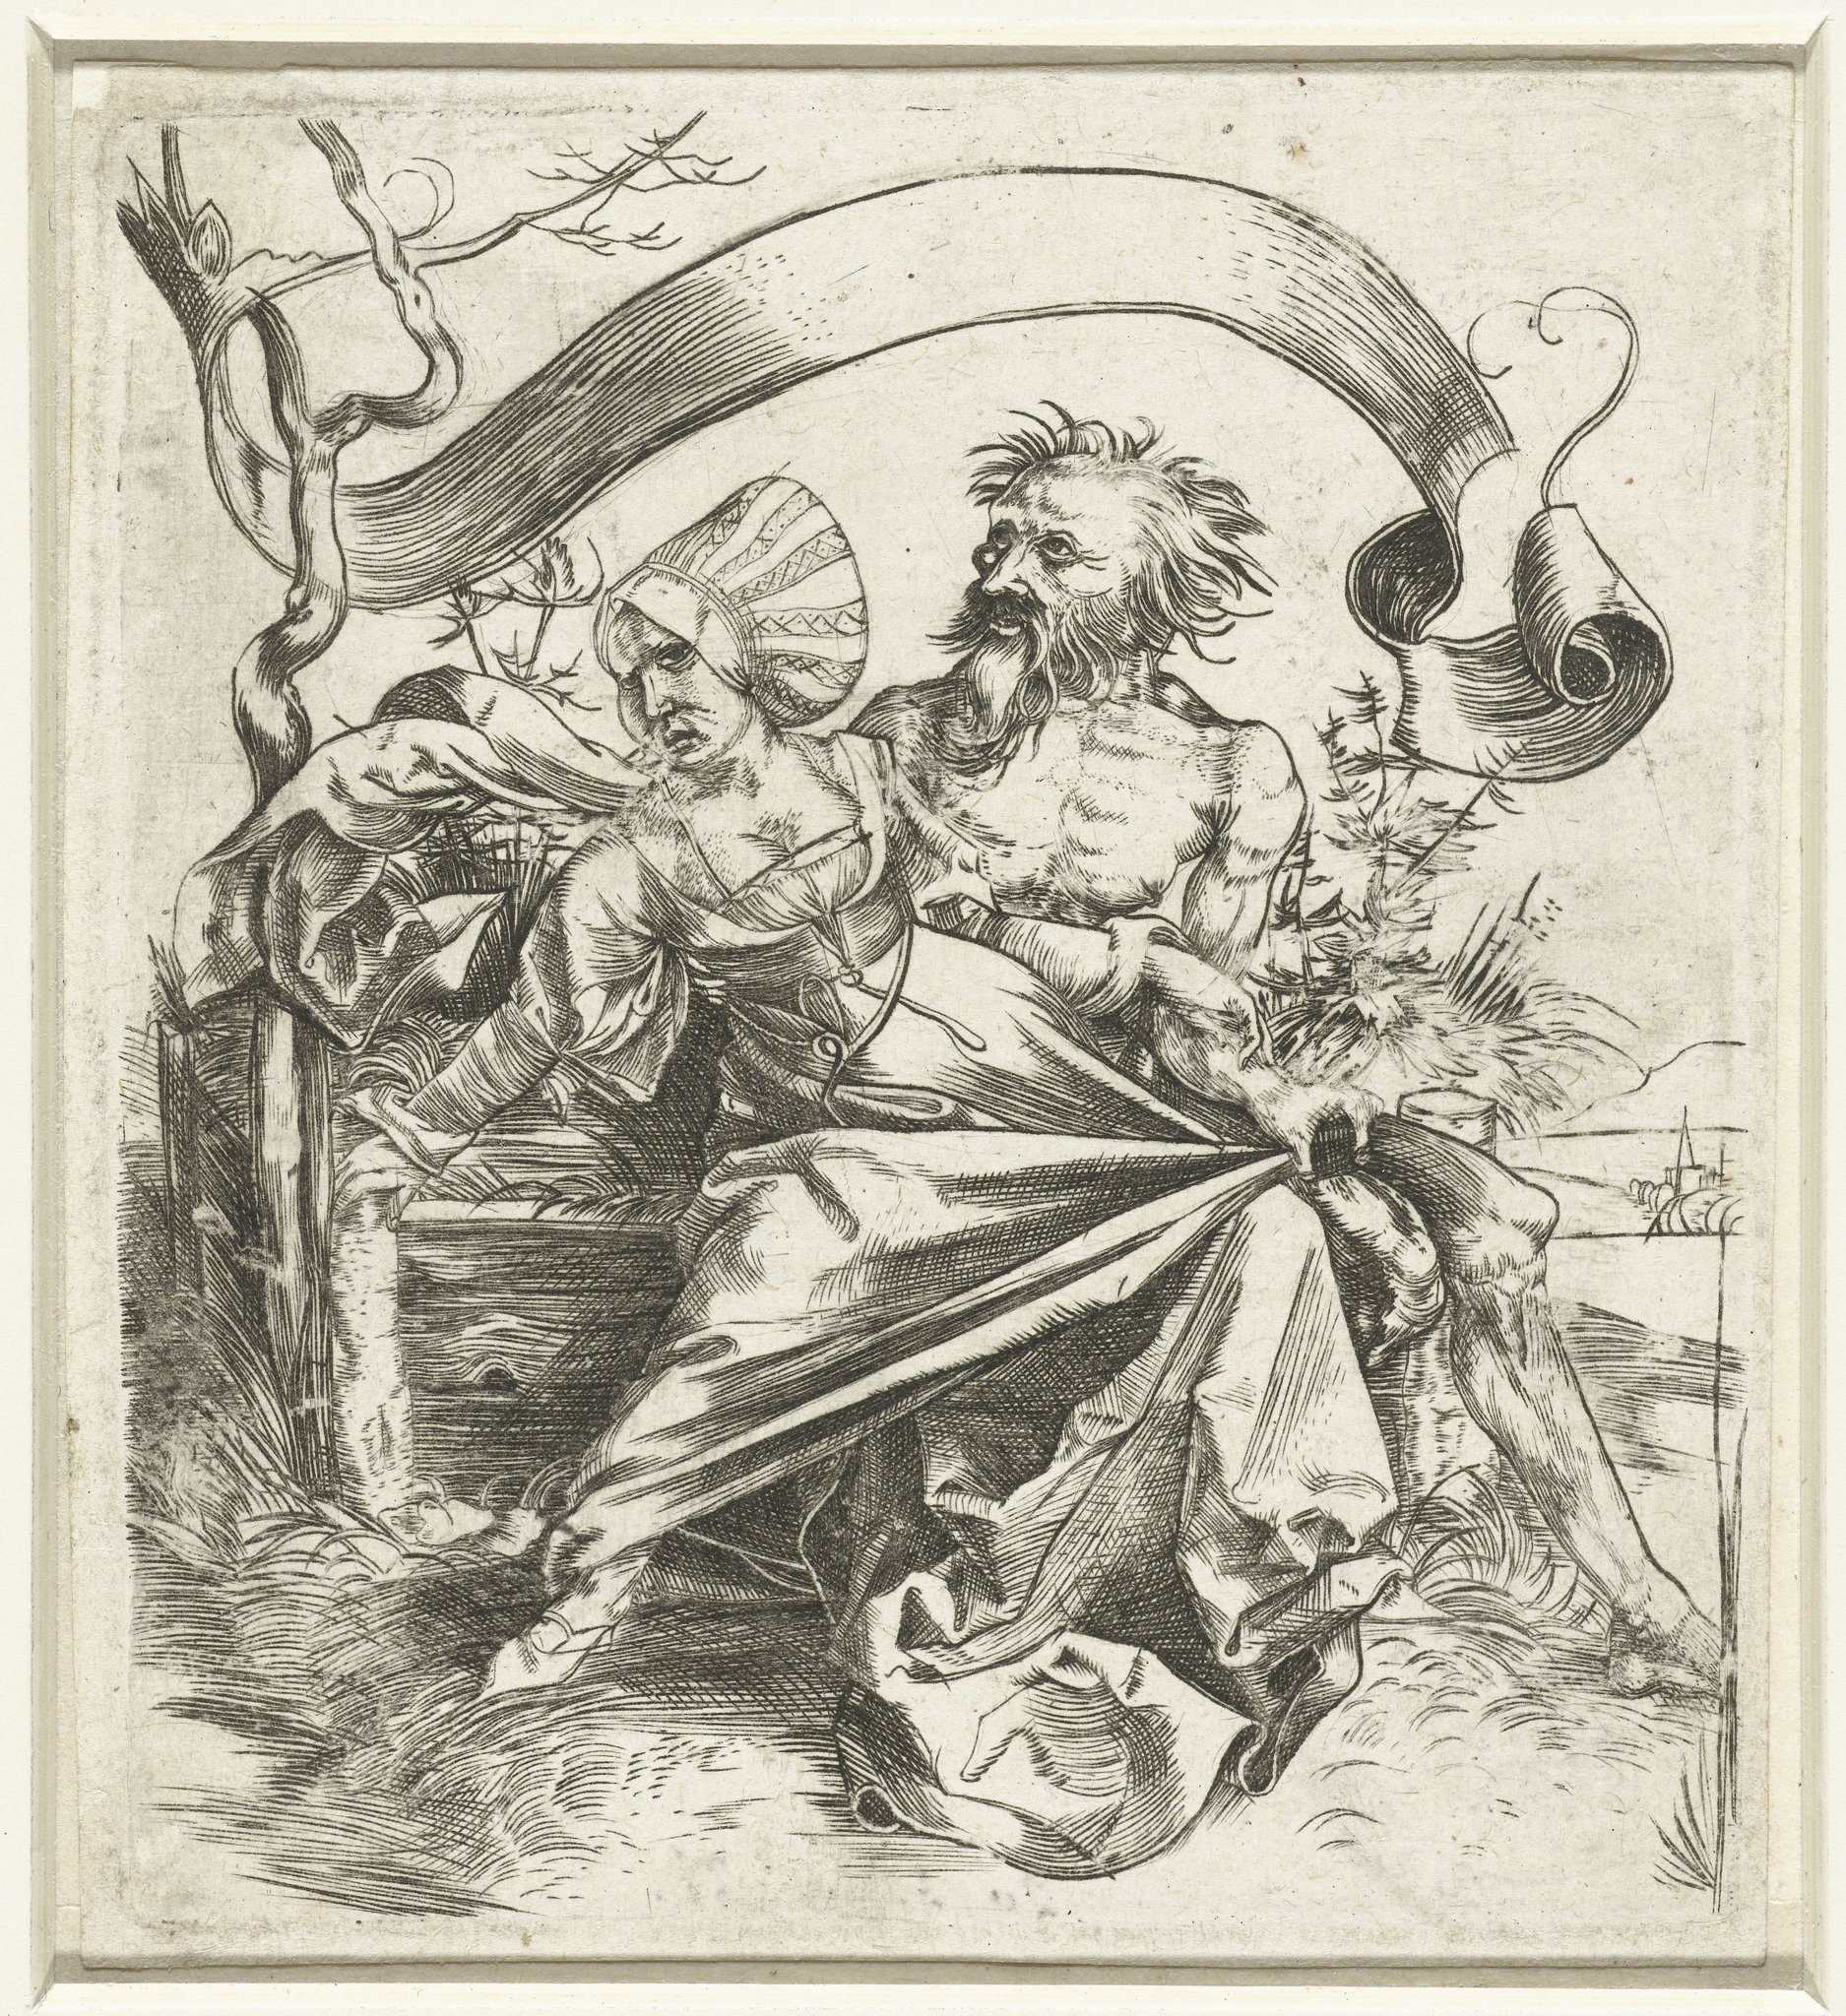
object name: print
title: De bruut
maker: Anonymous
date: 1493-1497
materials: paper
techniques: engraving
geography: germany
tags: adolescent, young woman, maiden, death as man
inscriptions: collector's mark: Lugt 240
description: Een jonge vrouw zit op een bank naast een blote man met wilde haren. Hij probeert haar te overweldigen, zij weert hem boos af.